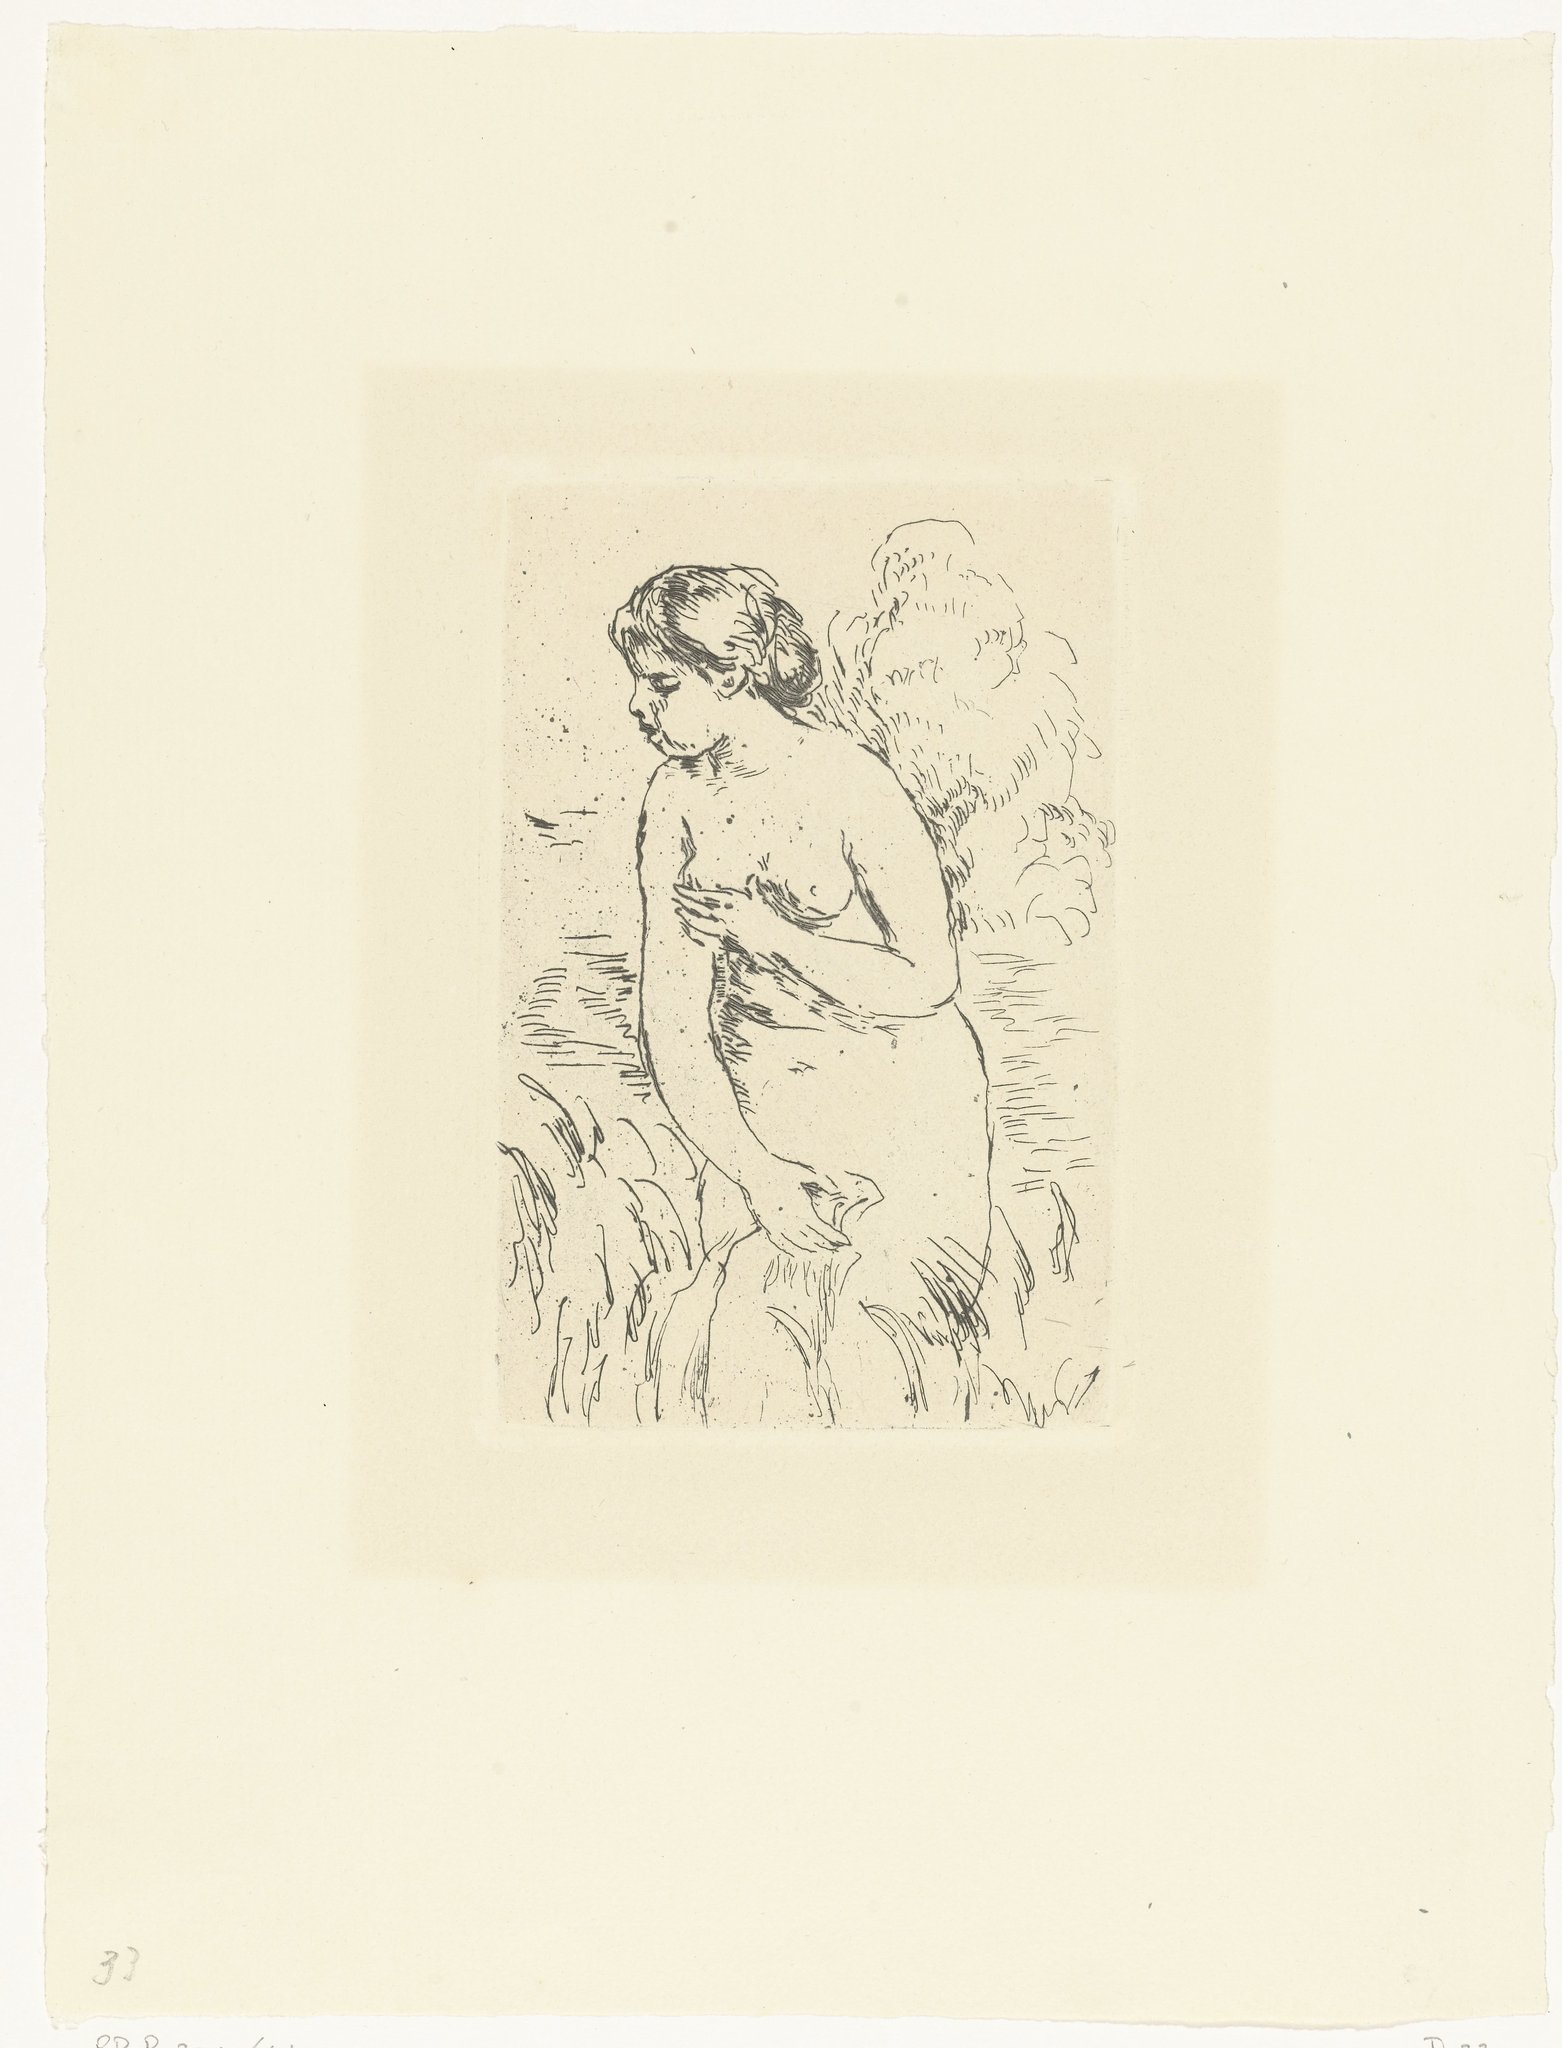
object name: print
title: Baigneux debout a mi-jambes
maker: pierre auguste renoir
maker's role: draughtsman, print maker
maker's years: 1841-1919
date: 1910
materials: paper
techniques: etching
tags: the (nude) human figure; 'corpo humano' (ripa), female sex; woman, in or beside the water (on the beach)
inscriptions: collector's mark: Lugt 2228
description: Eerste publicatie in: Théodore Duret, Manet and the French Impressionists, Londen 1910